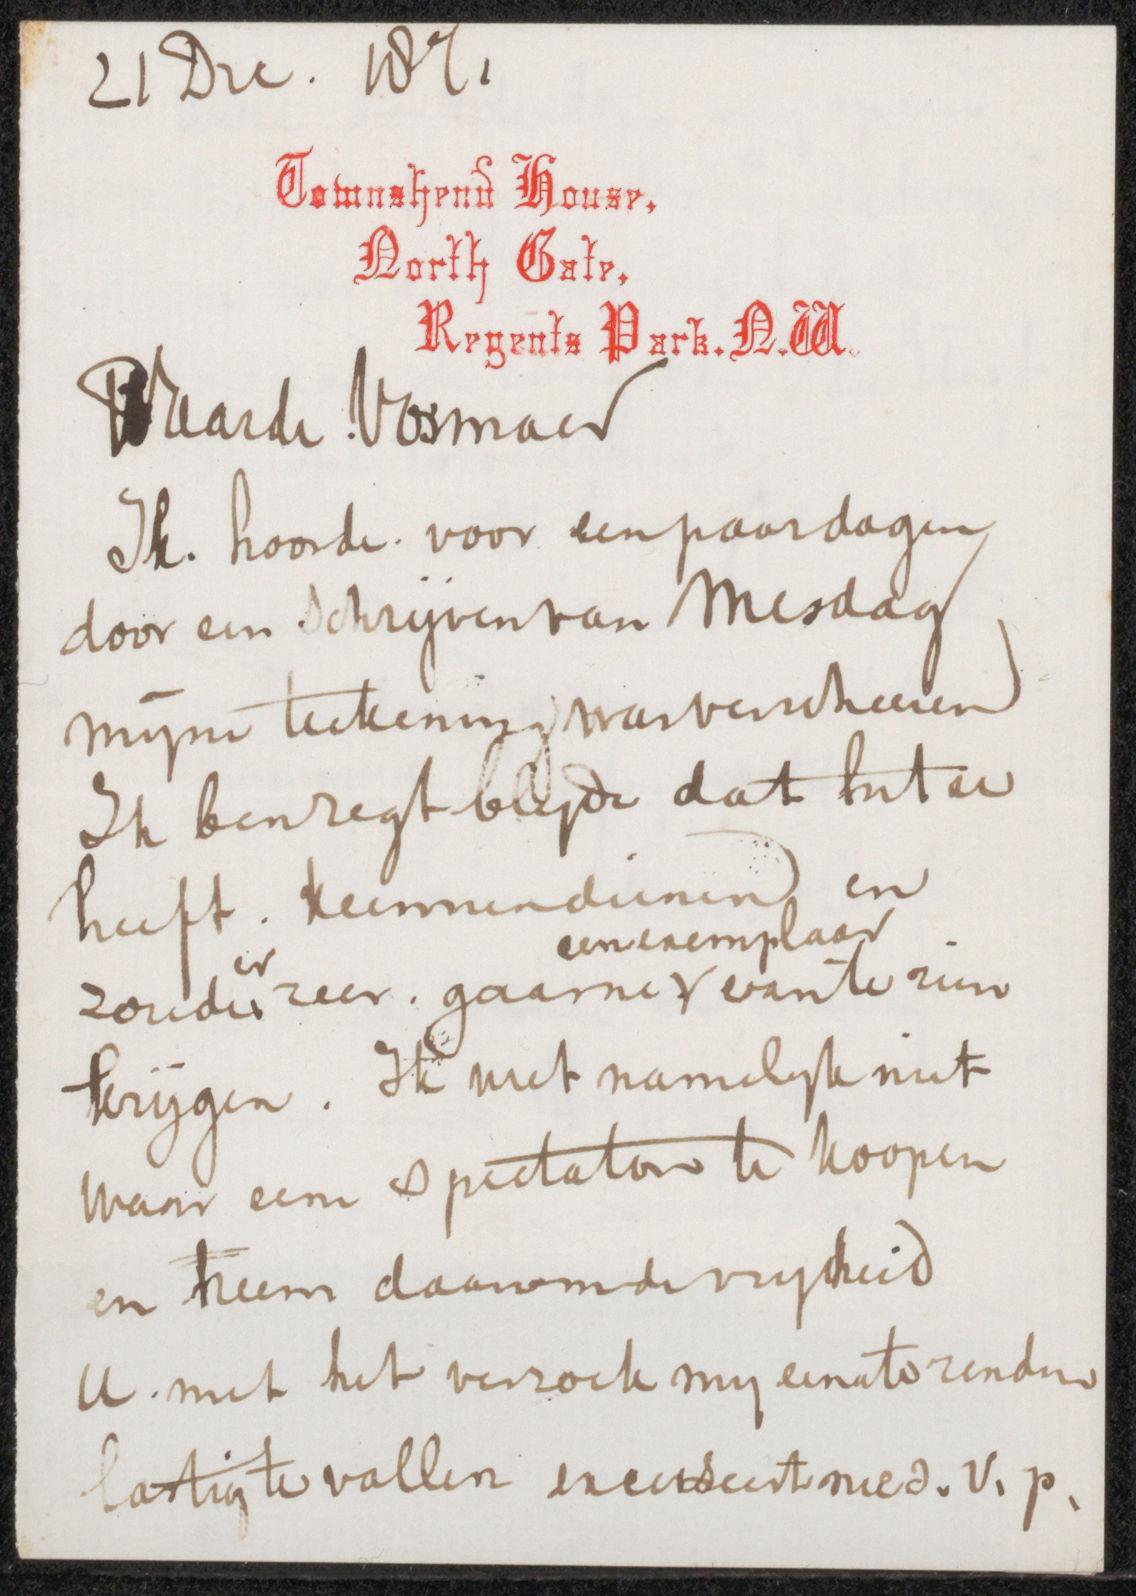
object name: letter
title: Brief aan Carel Vosmaer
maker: lourens alma tadema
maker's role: draughtsman, print maker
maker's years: 1836-1912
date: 1871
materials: ink, paper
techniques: pen, printing, writing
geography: london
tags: the hague, painter, hendrik willem mesdag, carel vosmaer, drawing, italy, brussels